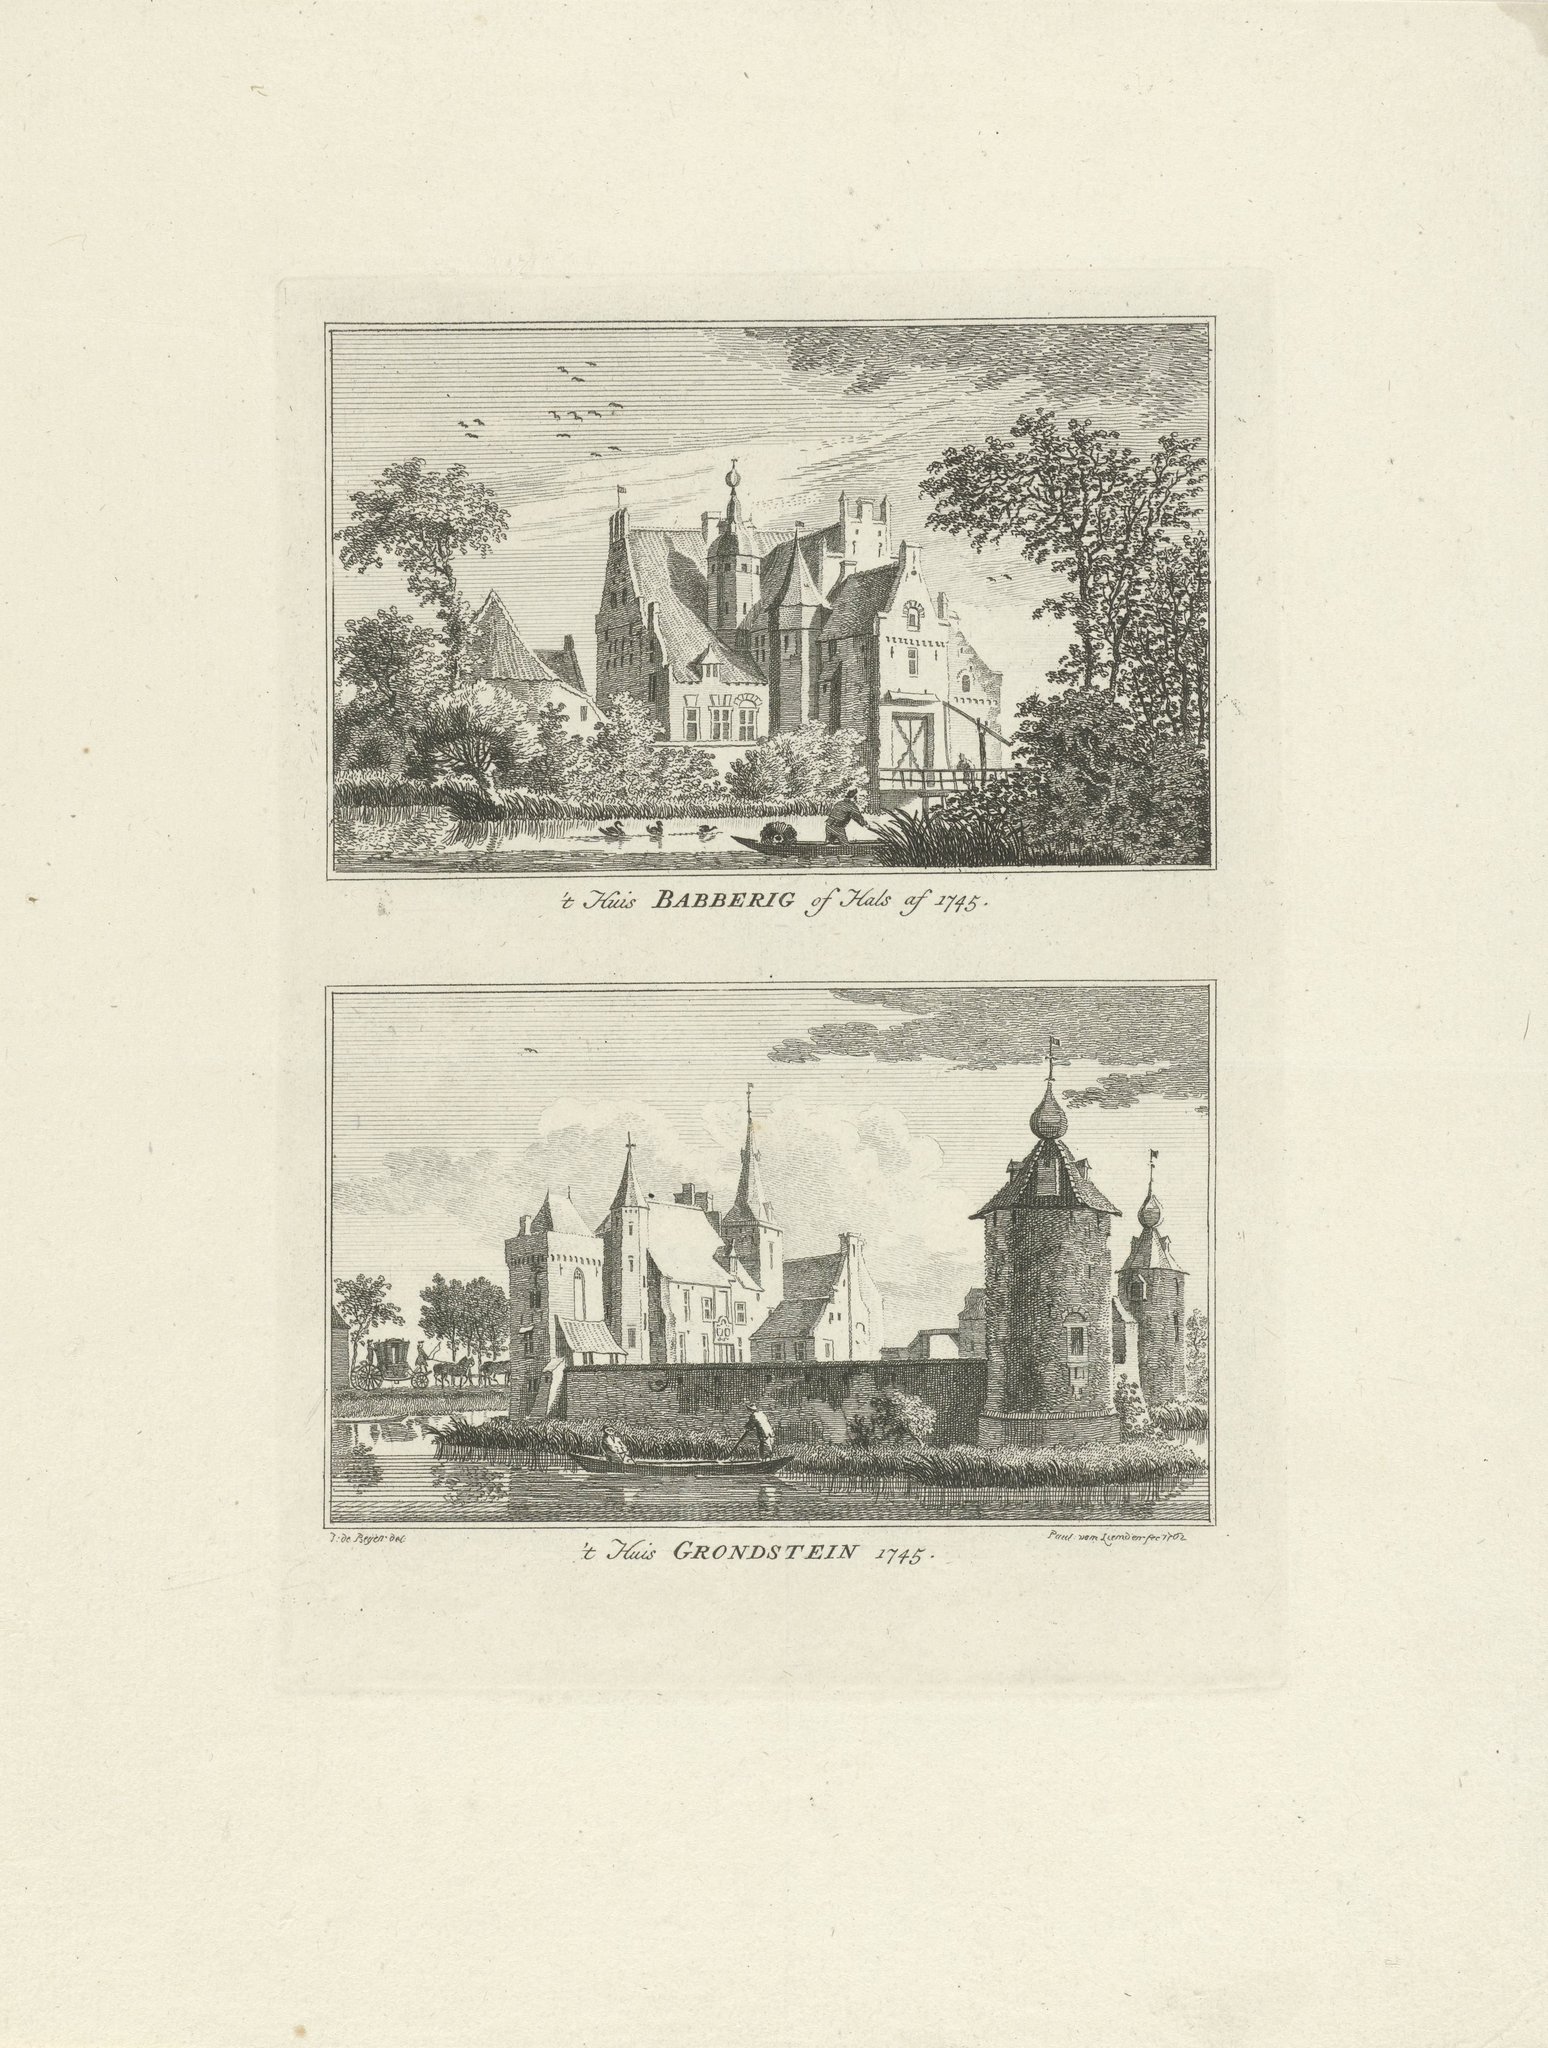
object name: print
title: 't Huis Babberig of Hals af 1745 / 't Huis Grondstein 1745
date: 1762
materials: paper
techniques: etching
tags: castle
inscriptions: collector's mark: Lugt 2228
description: Twee voorstellingen van één plaat. Gezicht op Kasteel Halsaf in Babberich (boven) en Kasteel Grondstein nabij het Duitse dorp Elten (onder). De prent maakt deel uit van een 100-delige serie met gezichten op dorpen en steden te Kleef.